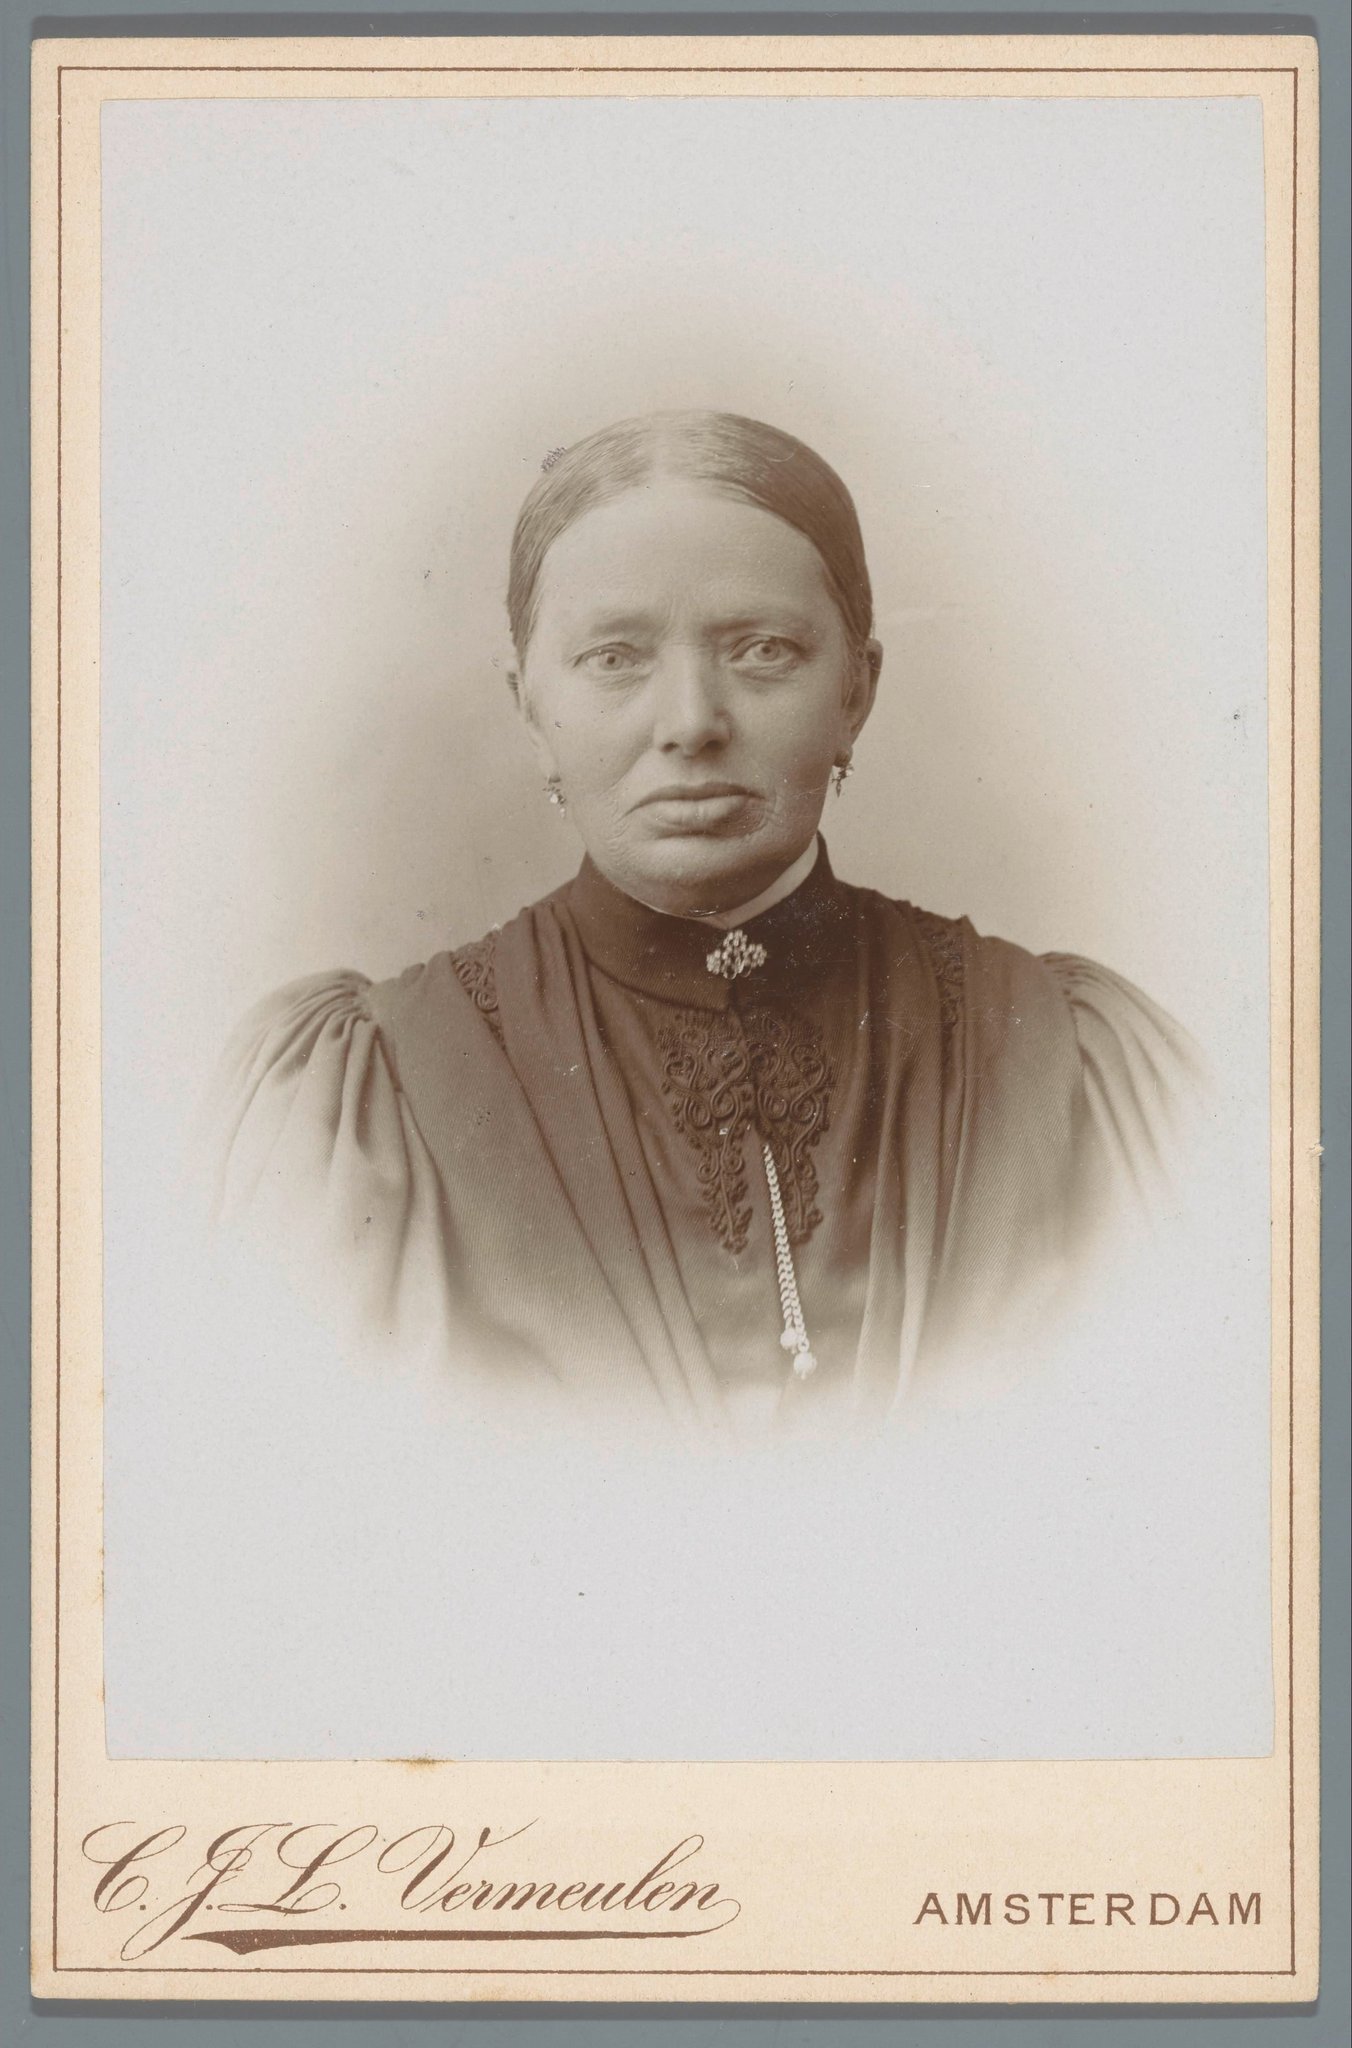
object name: cabinet photograph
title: Portret van een onbekende vrouw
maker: cornelis johannes lodewicus vermeulen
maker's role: fotograaf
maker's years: 1861-1936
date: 1890-1910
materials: cardboard, photographic support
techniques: collodion silver print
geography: amsterdam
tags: adult woman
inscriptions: inscription: ‘Photographische Ateliers (...) Specialiteit in vergrootingen.’